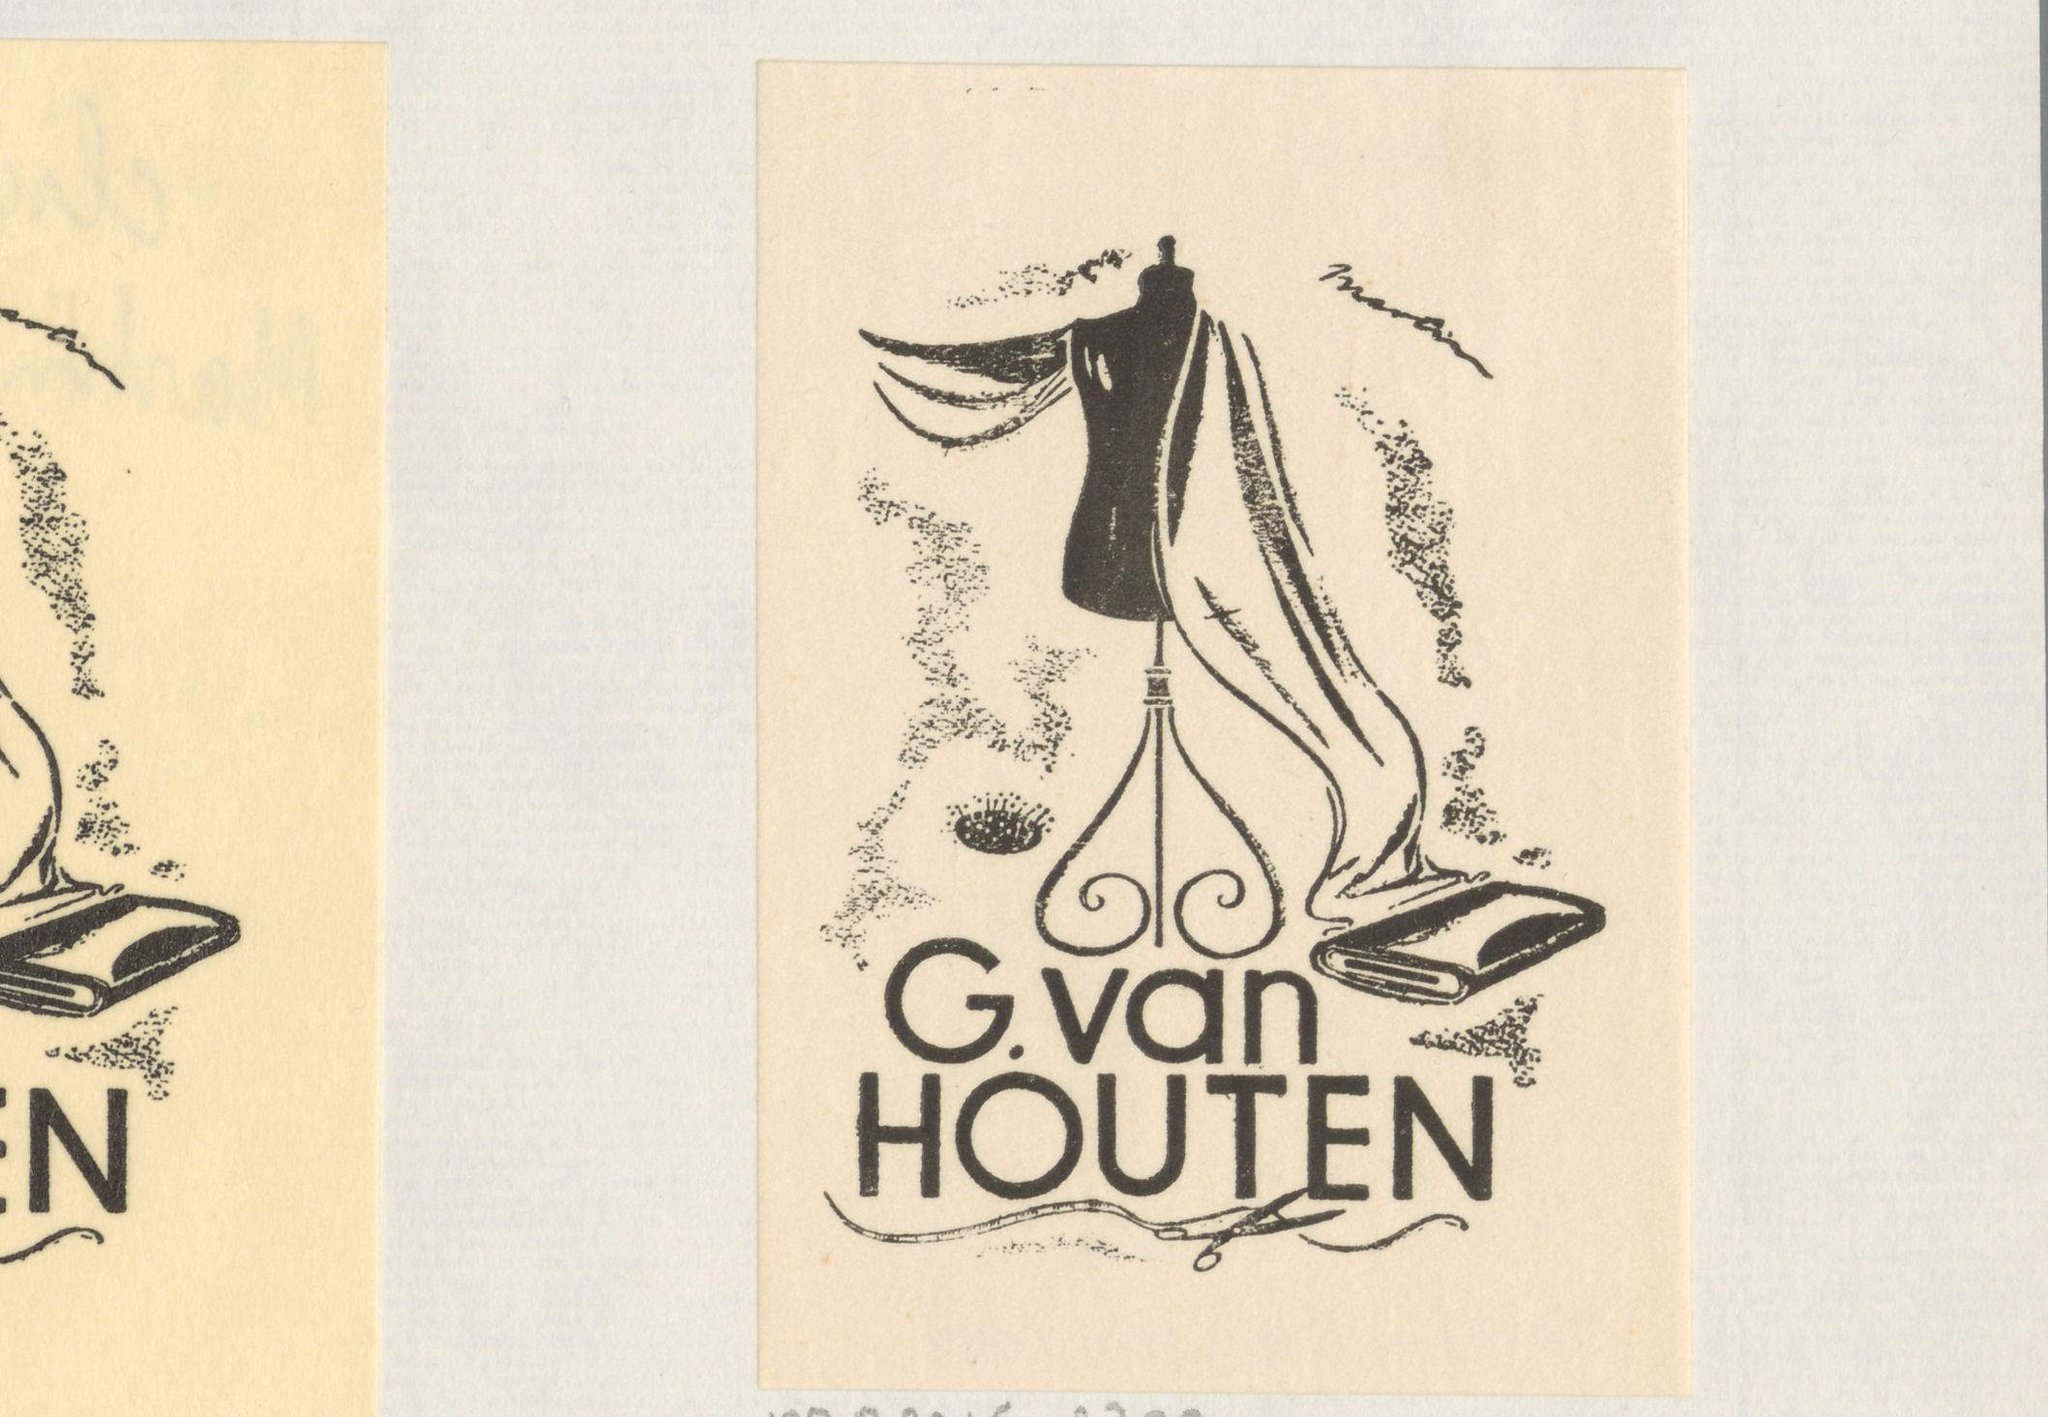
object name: bookplate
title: Ex libris van G. van Houten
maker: martin horwitz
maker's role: print maker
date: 1942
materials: paper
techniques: printing block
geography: netherlands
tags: model, mannequin, textile fabric, cloth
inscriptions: inscription: ‘Martin Horwitz '42’